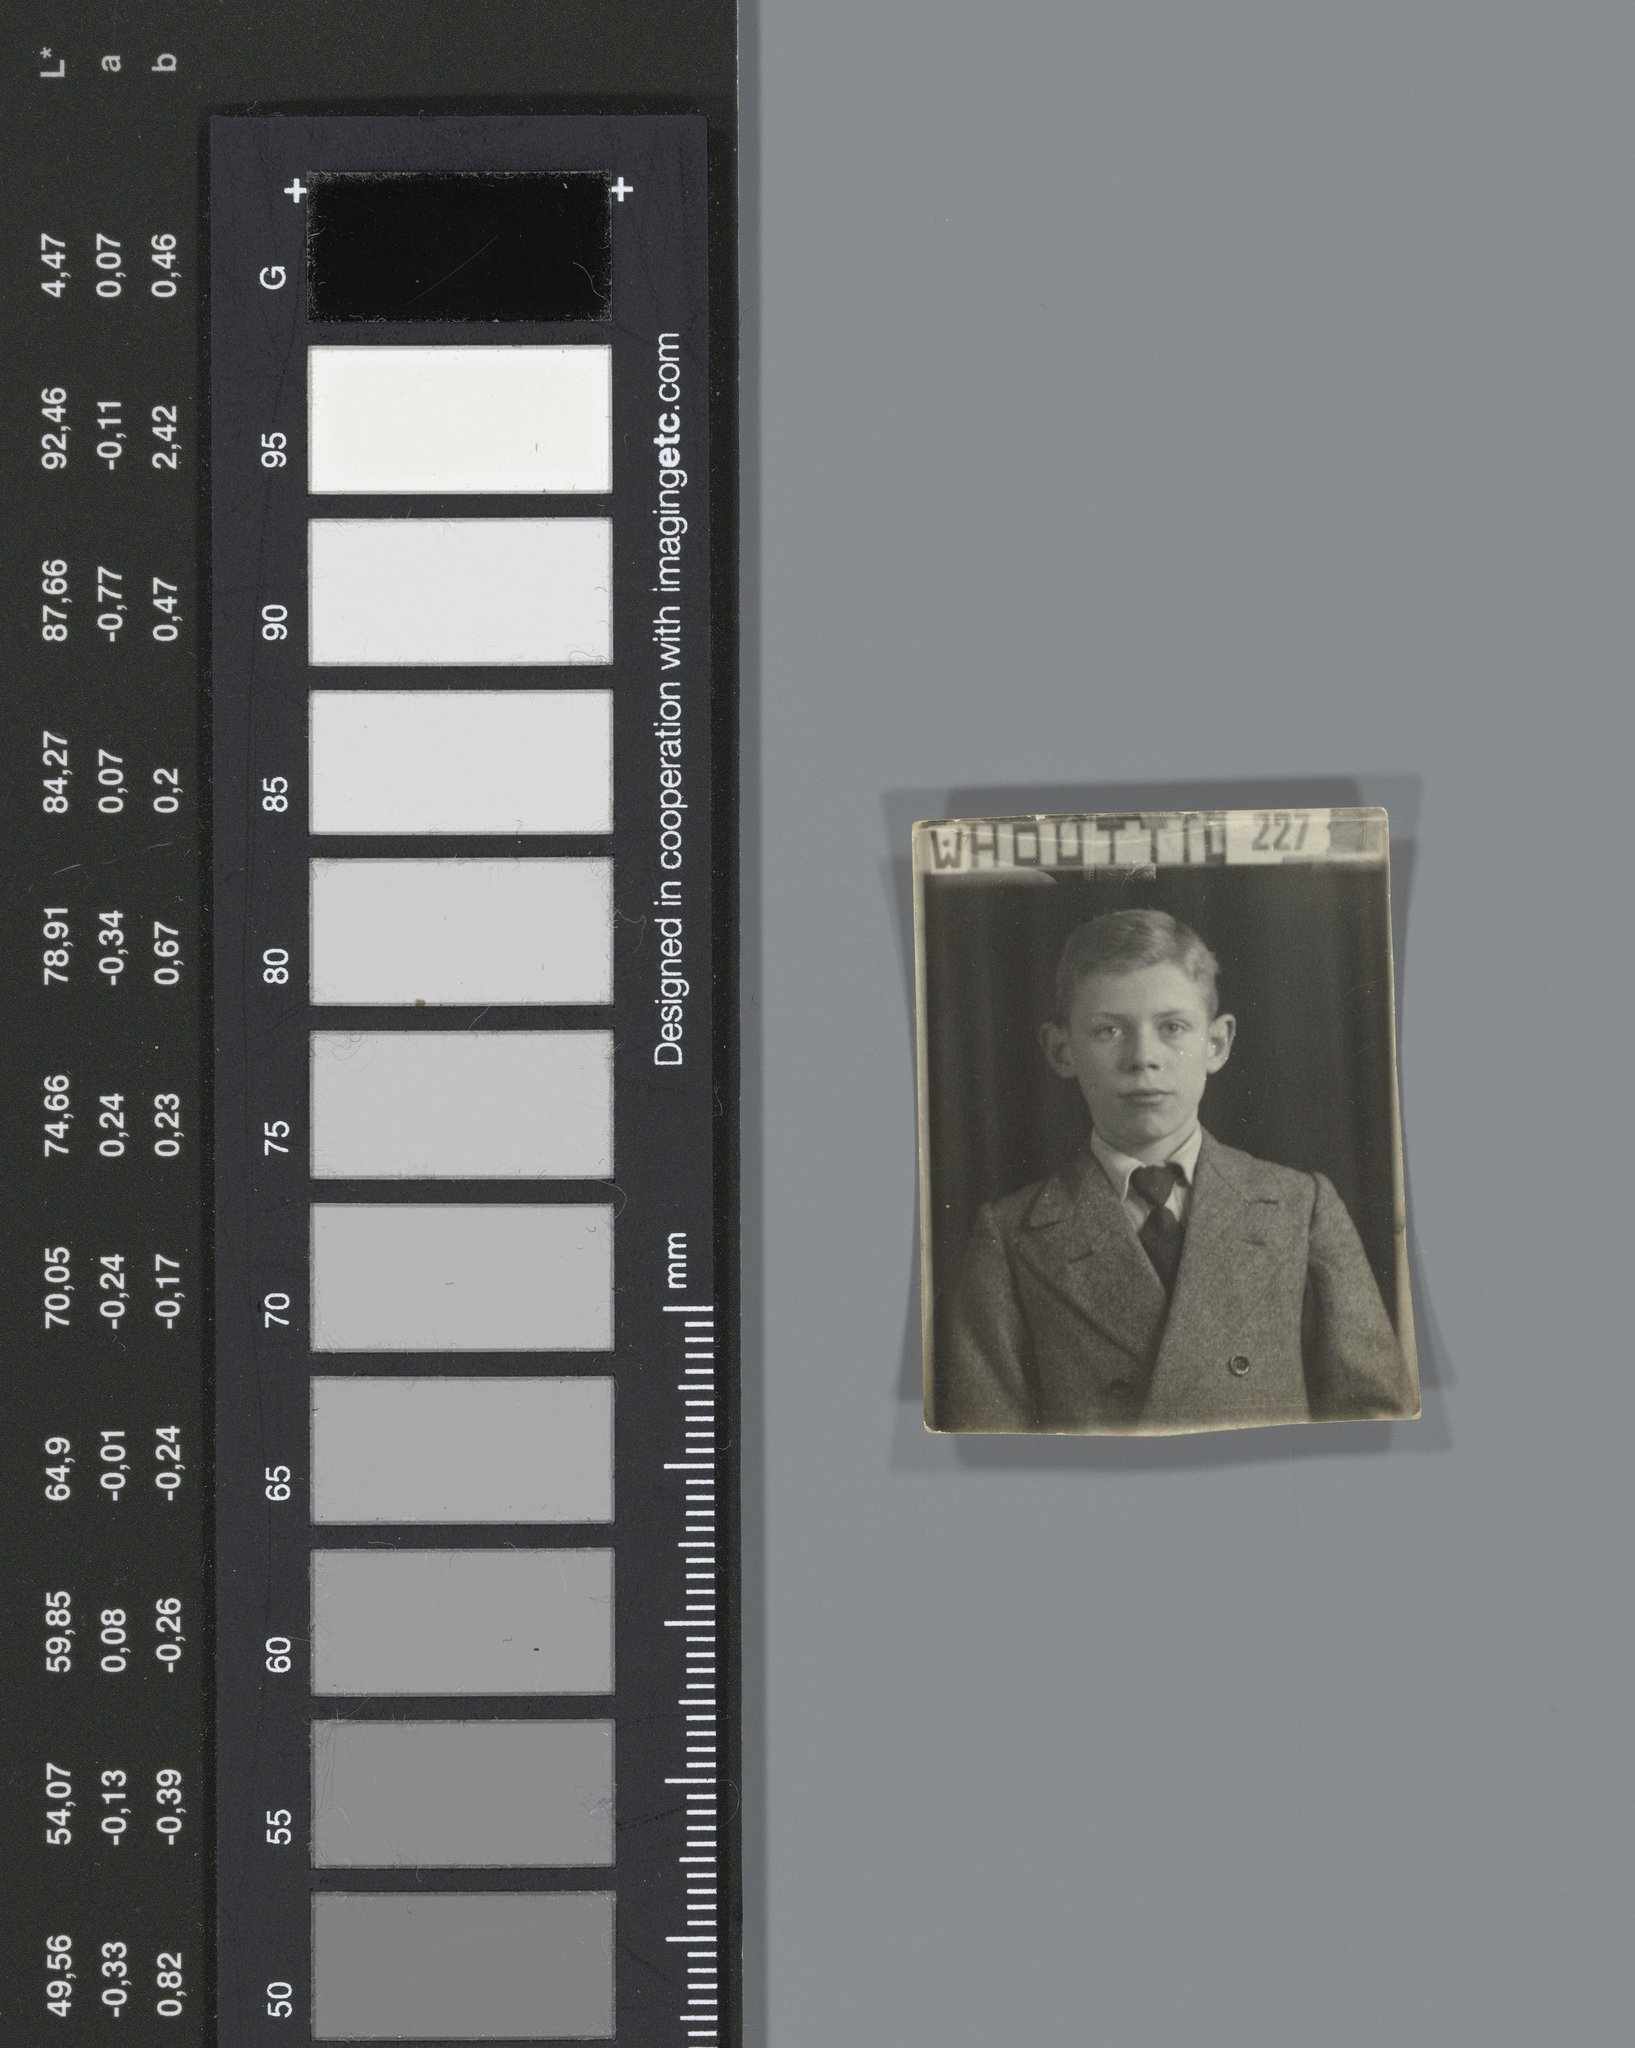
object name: snapshot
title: Rapid photographs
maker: jan gottfried stütner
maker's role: fotograaf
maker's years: 1892-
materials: photographic support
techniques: gelatin silver print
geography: alkmaar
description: Between 1912 and 1930, anyone could have their portrait taken at the many so-called rapid photography studios in the shopping streets of mainly (medium) large-size European cities. As if on an assembly line, the youngest clerk shot the photographs with a special camera and in artificial light and developed them. Later in the day, the customer collected a sheet with 12 portrait photos for 25 cents. This form of photographic mass production gave rise to a fascinating tableau of boys, girls, men and women not previously seen in photographs; candid and informal. There were at least 150 quick-photo studios, from Alkmaar to Zutphen. Many called themselves ‘American,’ mistakenly as it turns out because hardly any examples from that country have been found.